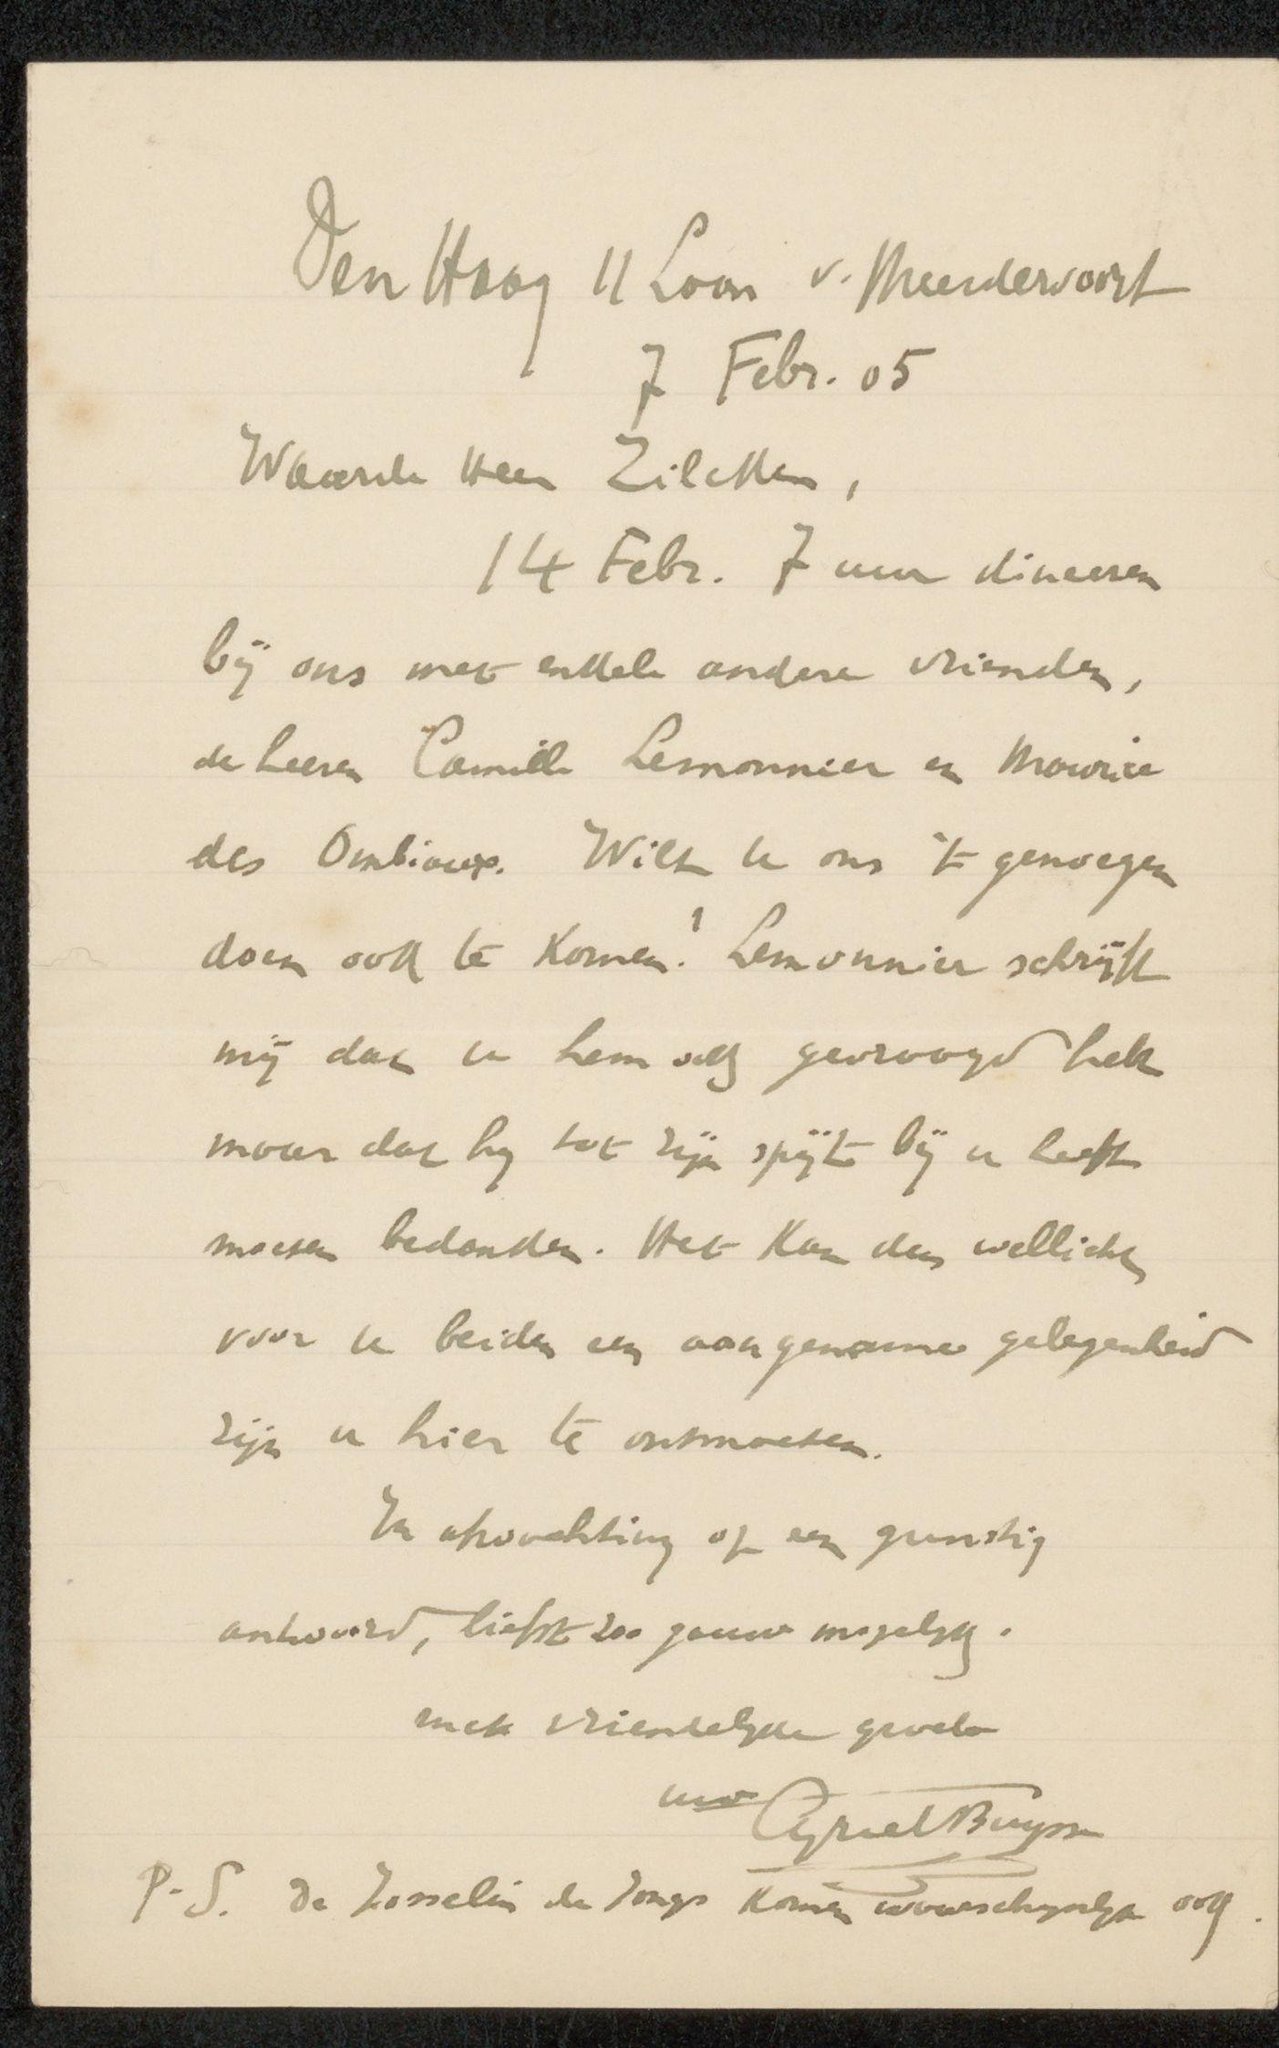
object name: letter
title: Brief aan Philip Zilcken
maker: cyriel buysse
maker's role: schrijver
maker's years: 1859-1932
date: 1905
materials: ink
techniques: pen, writing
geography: the hague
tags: camille lemonnier, the hague, painter, draughtsman, philip zilcken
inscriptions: collector's mark: ‘RPK’